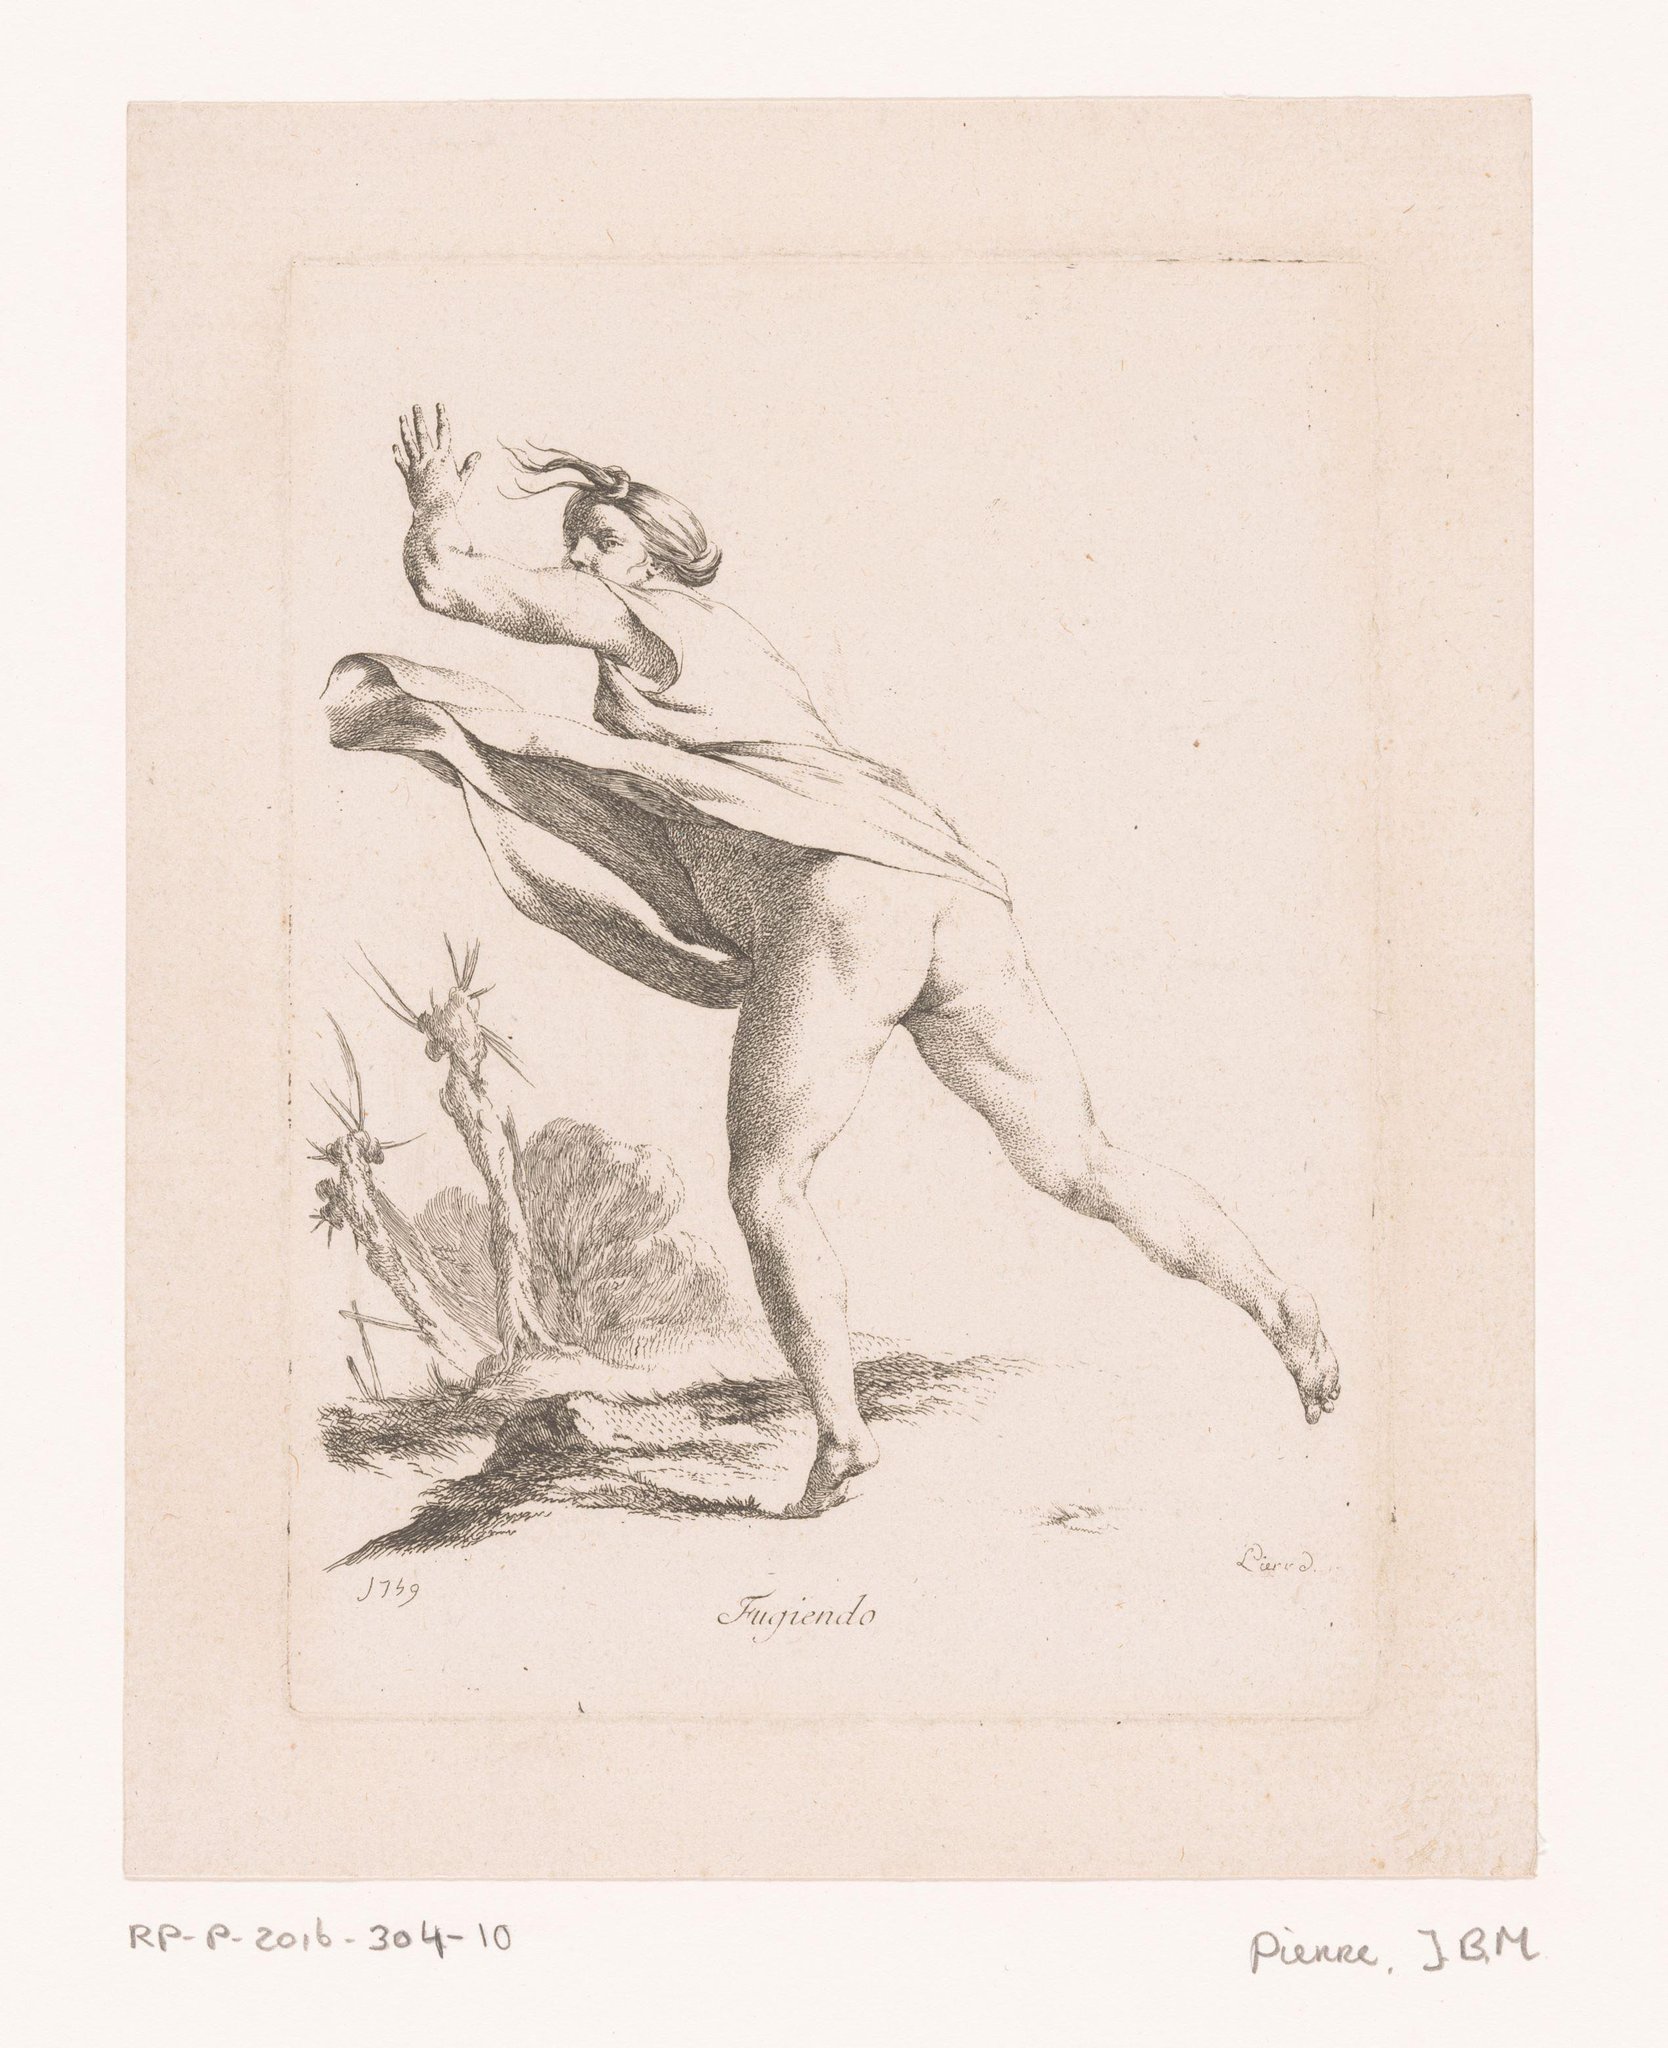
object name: print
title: Vluchtende vrouw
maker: jean baptiste marie pierre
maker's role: print maker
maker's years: 1713-1789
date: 1759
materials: paper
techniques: etching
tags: running - aa - female human figure, flight, running away; pursuing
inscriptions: collector's mark: Lugt 2760, collector's mark: Lugt 2228